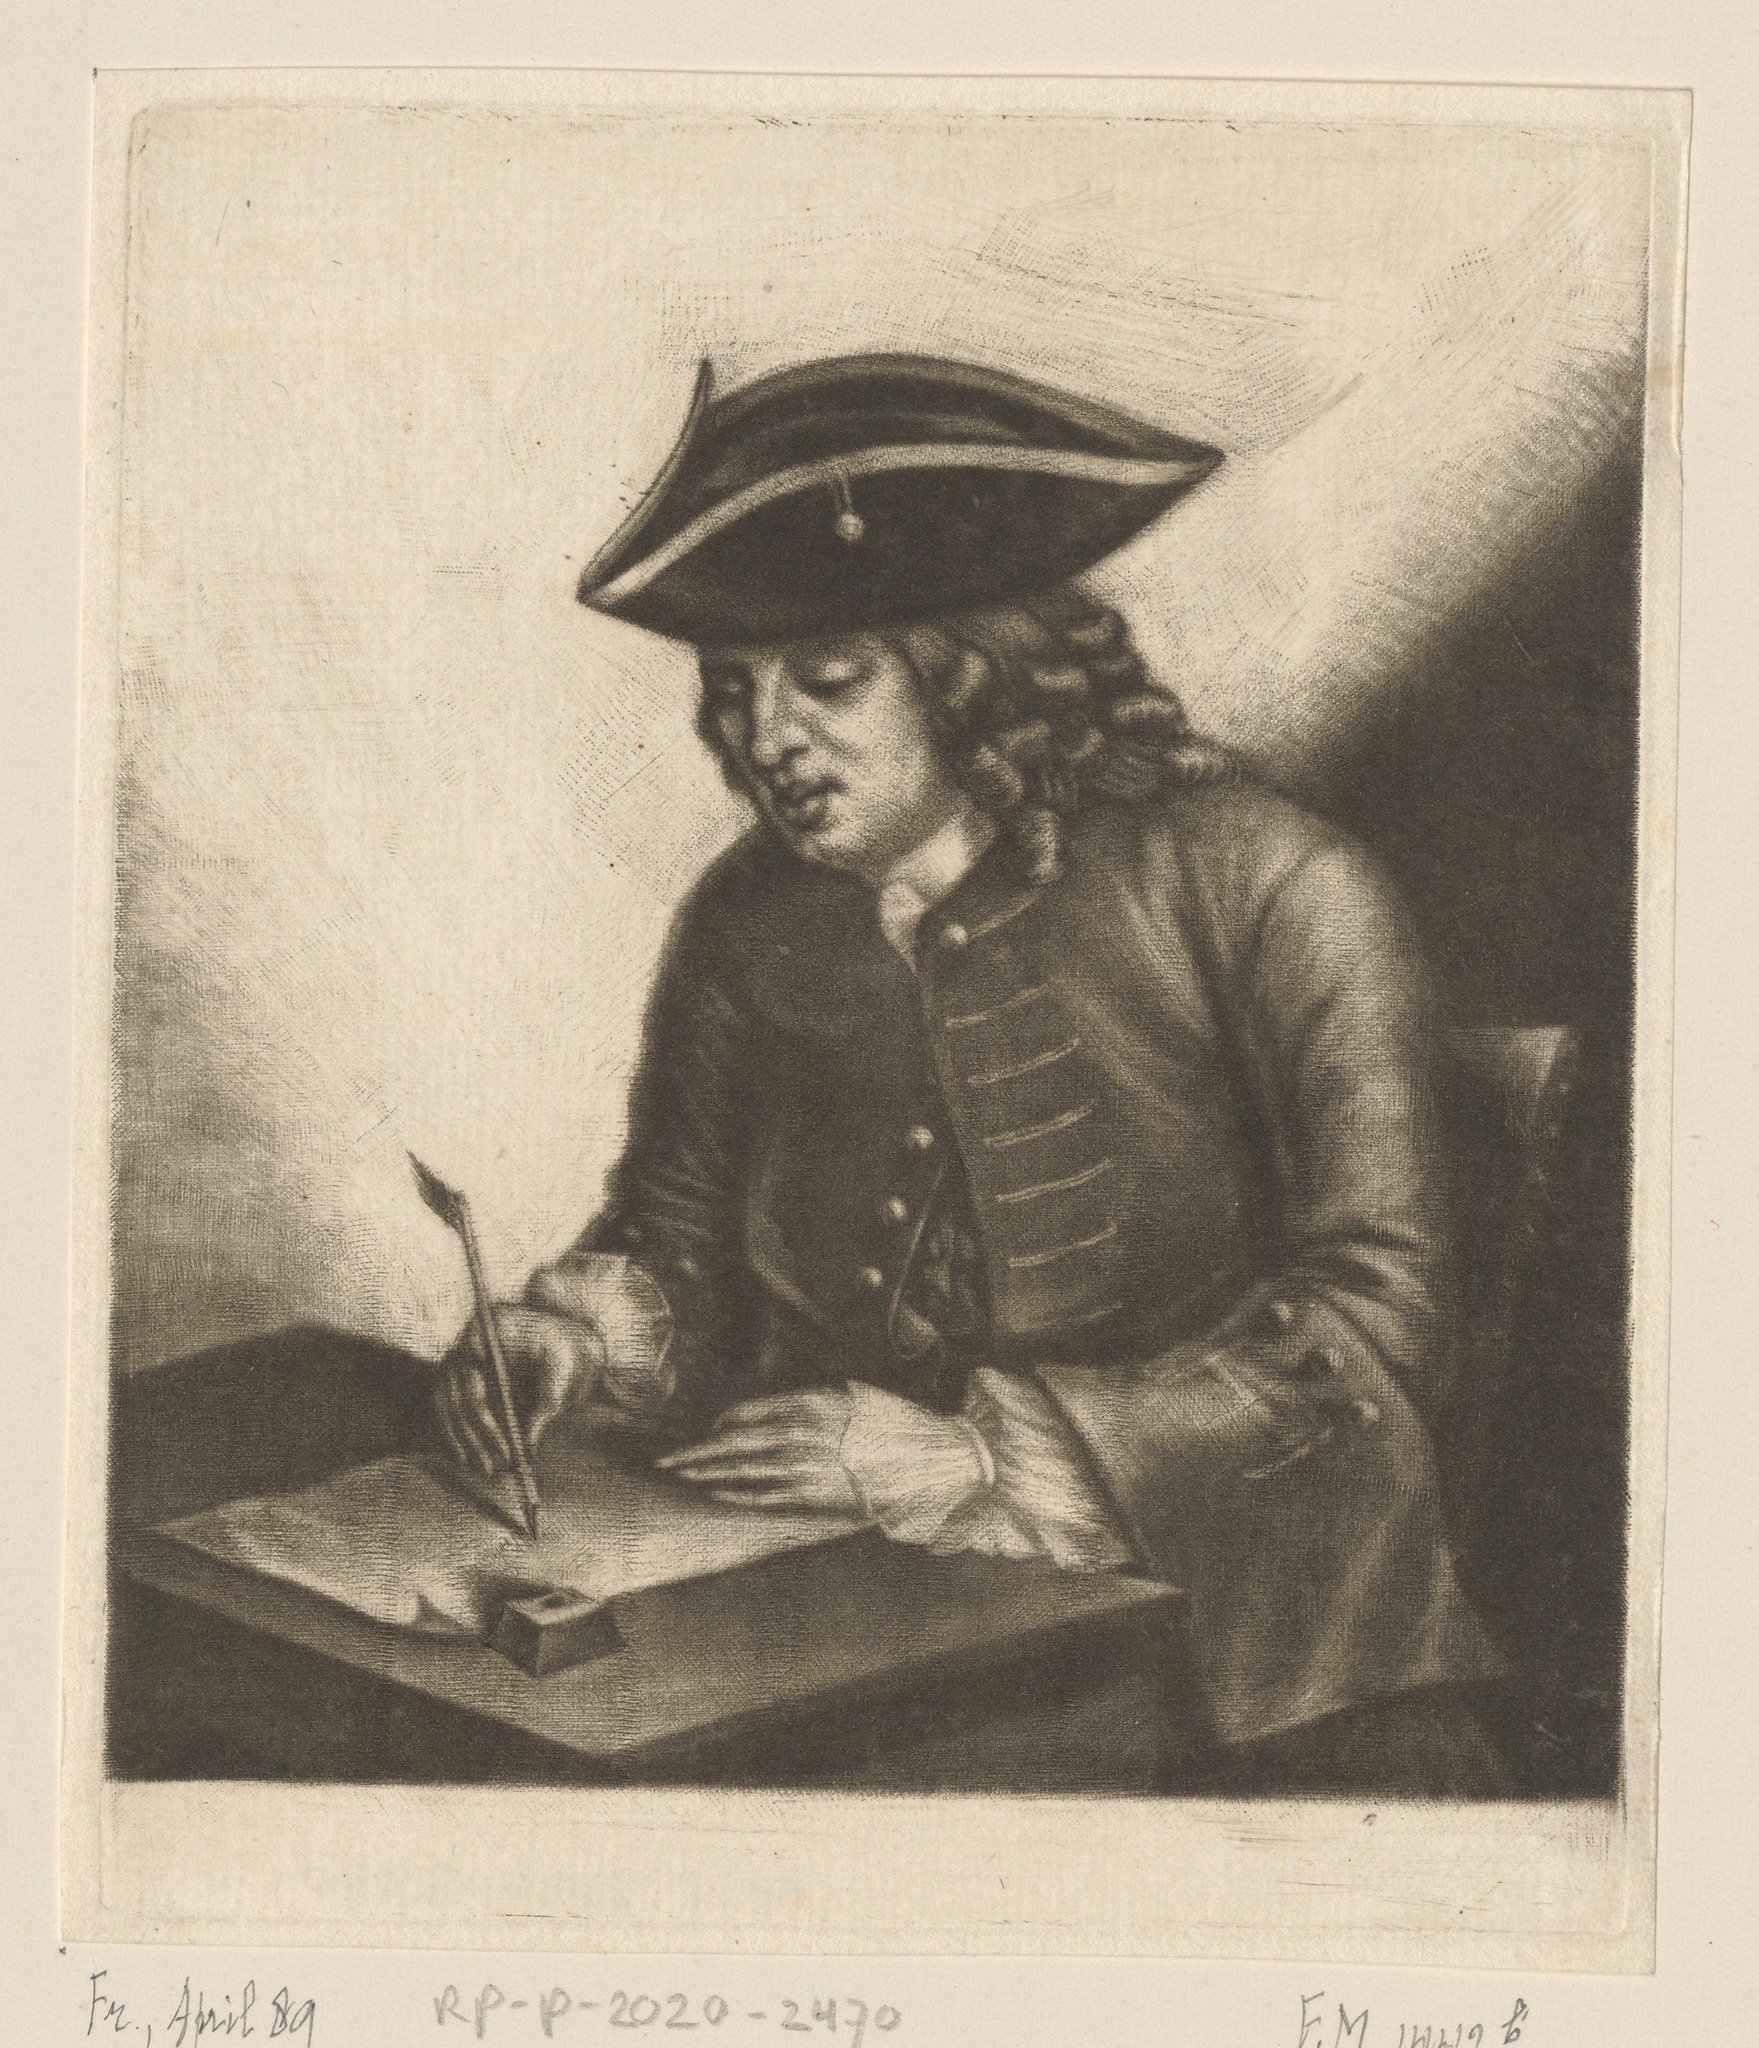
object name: print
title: Portret van een schrijvende man aan een bureau, mogelijk Pieter Louw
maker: john greenwood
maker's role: auctioneer, draughtsman, print maker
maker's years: 1727-1792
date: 1758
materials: paper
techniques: mezzotint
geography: amsterdam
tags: pieter louw, handwriting, writing as activity, historical persons, portrait, self-portrait of graphic artist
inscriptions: inscription: ‘April : 89’, collector's mark: Lugt 964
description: Prent is mogelijk een portret van Pieter Louw, zie ook de tekening met het portret van Louw met een pijp, schrijvend aan een bureau, door Greenwood in het British Museum.